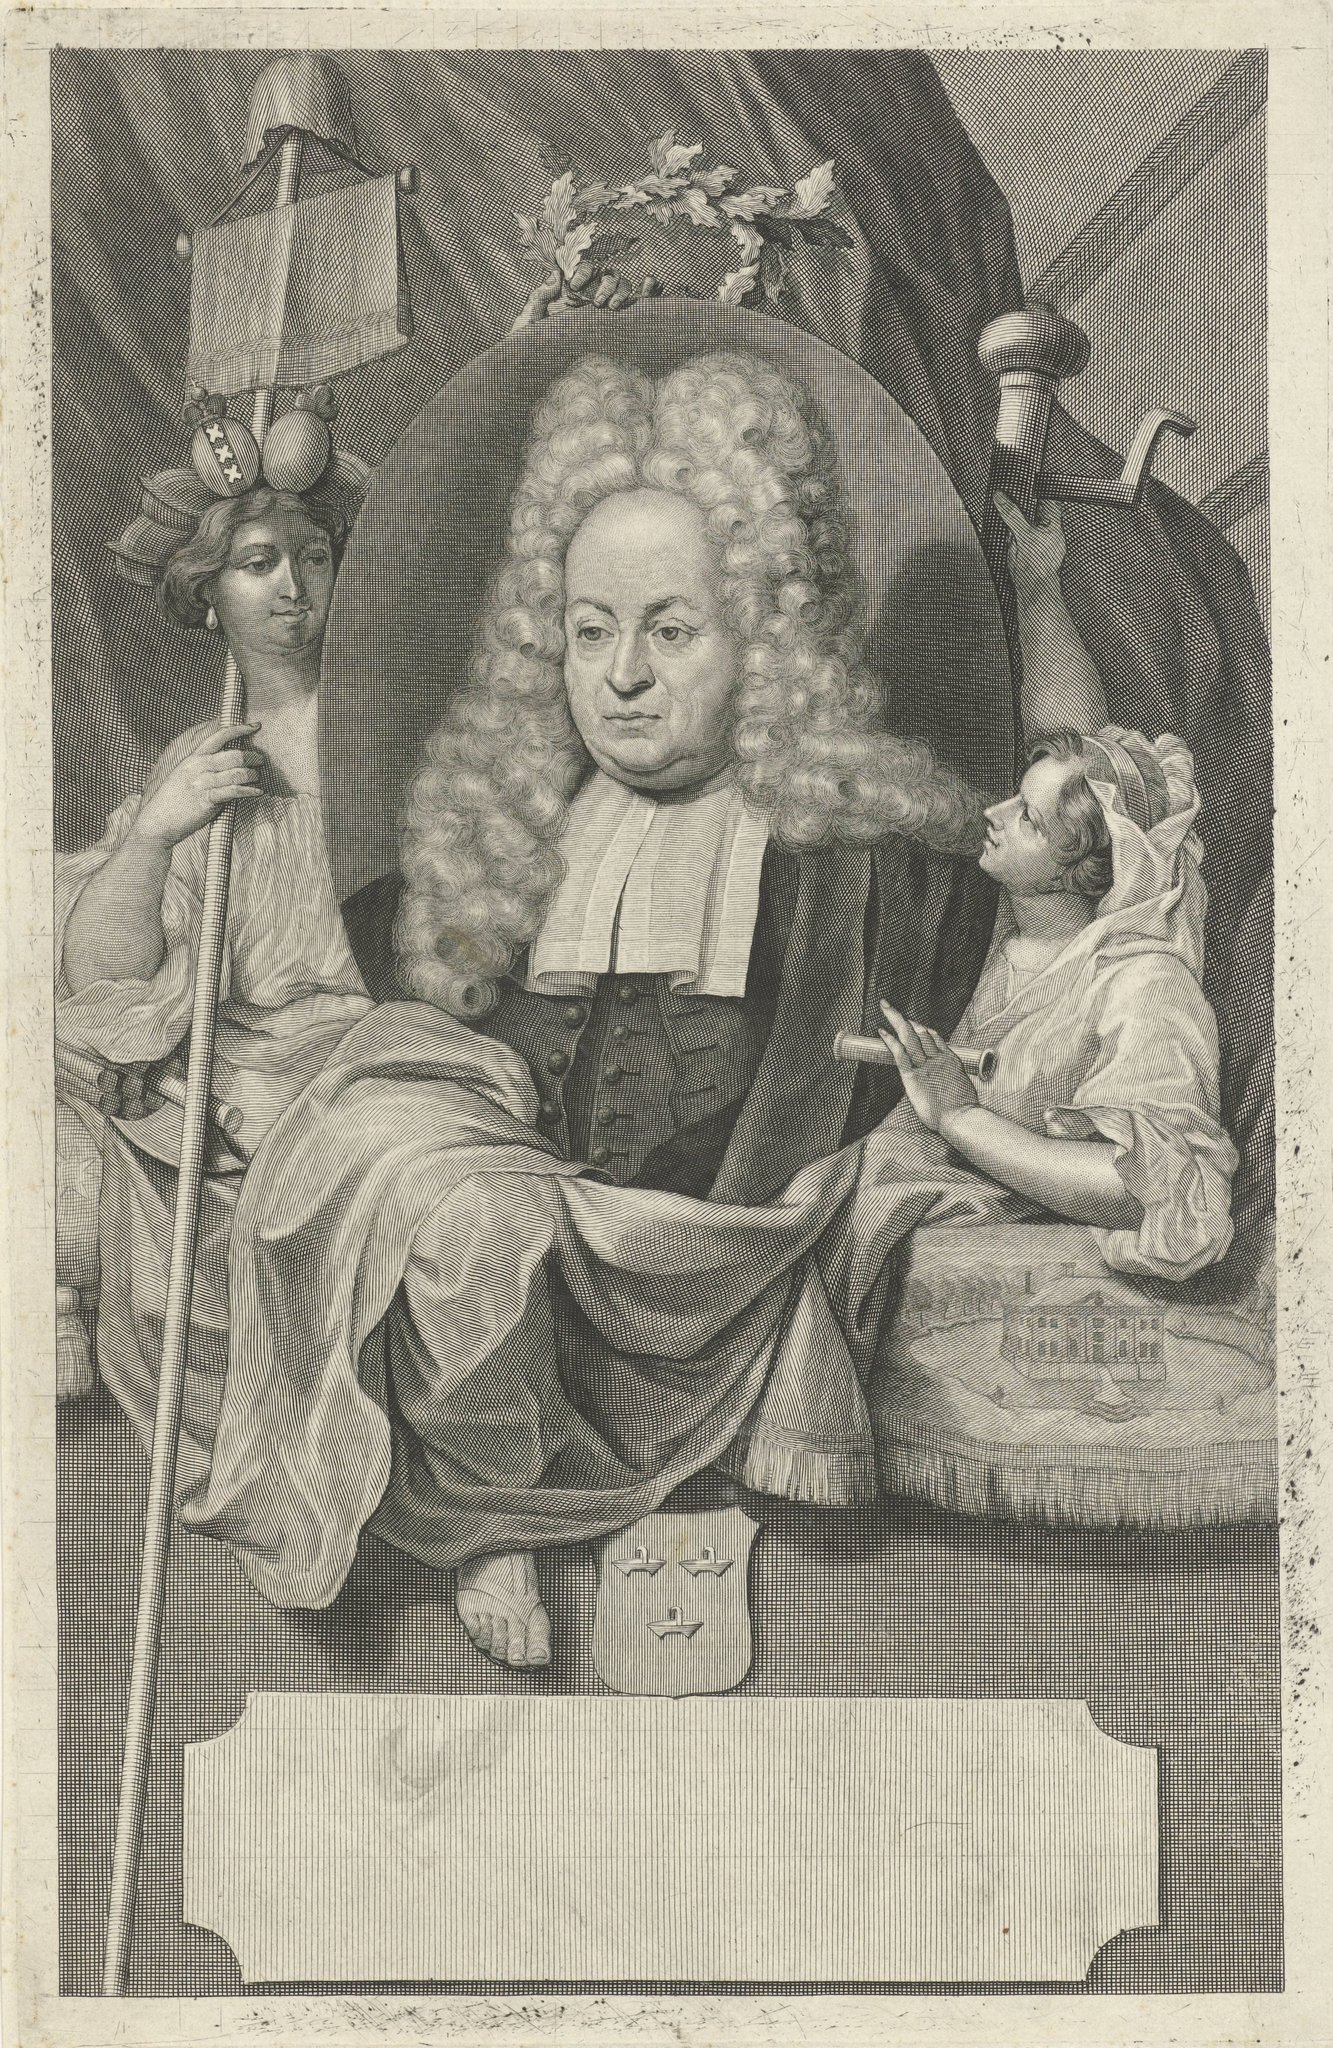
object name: print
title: Portret van Jan Trip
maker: jacob houbraken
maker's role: draughtsman, print maker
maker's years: 1698-1780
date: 1708-1780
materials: paper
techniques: engraving